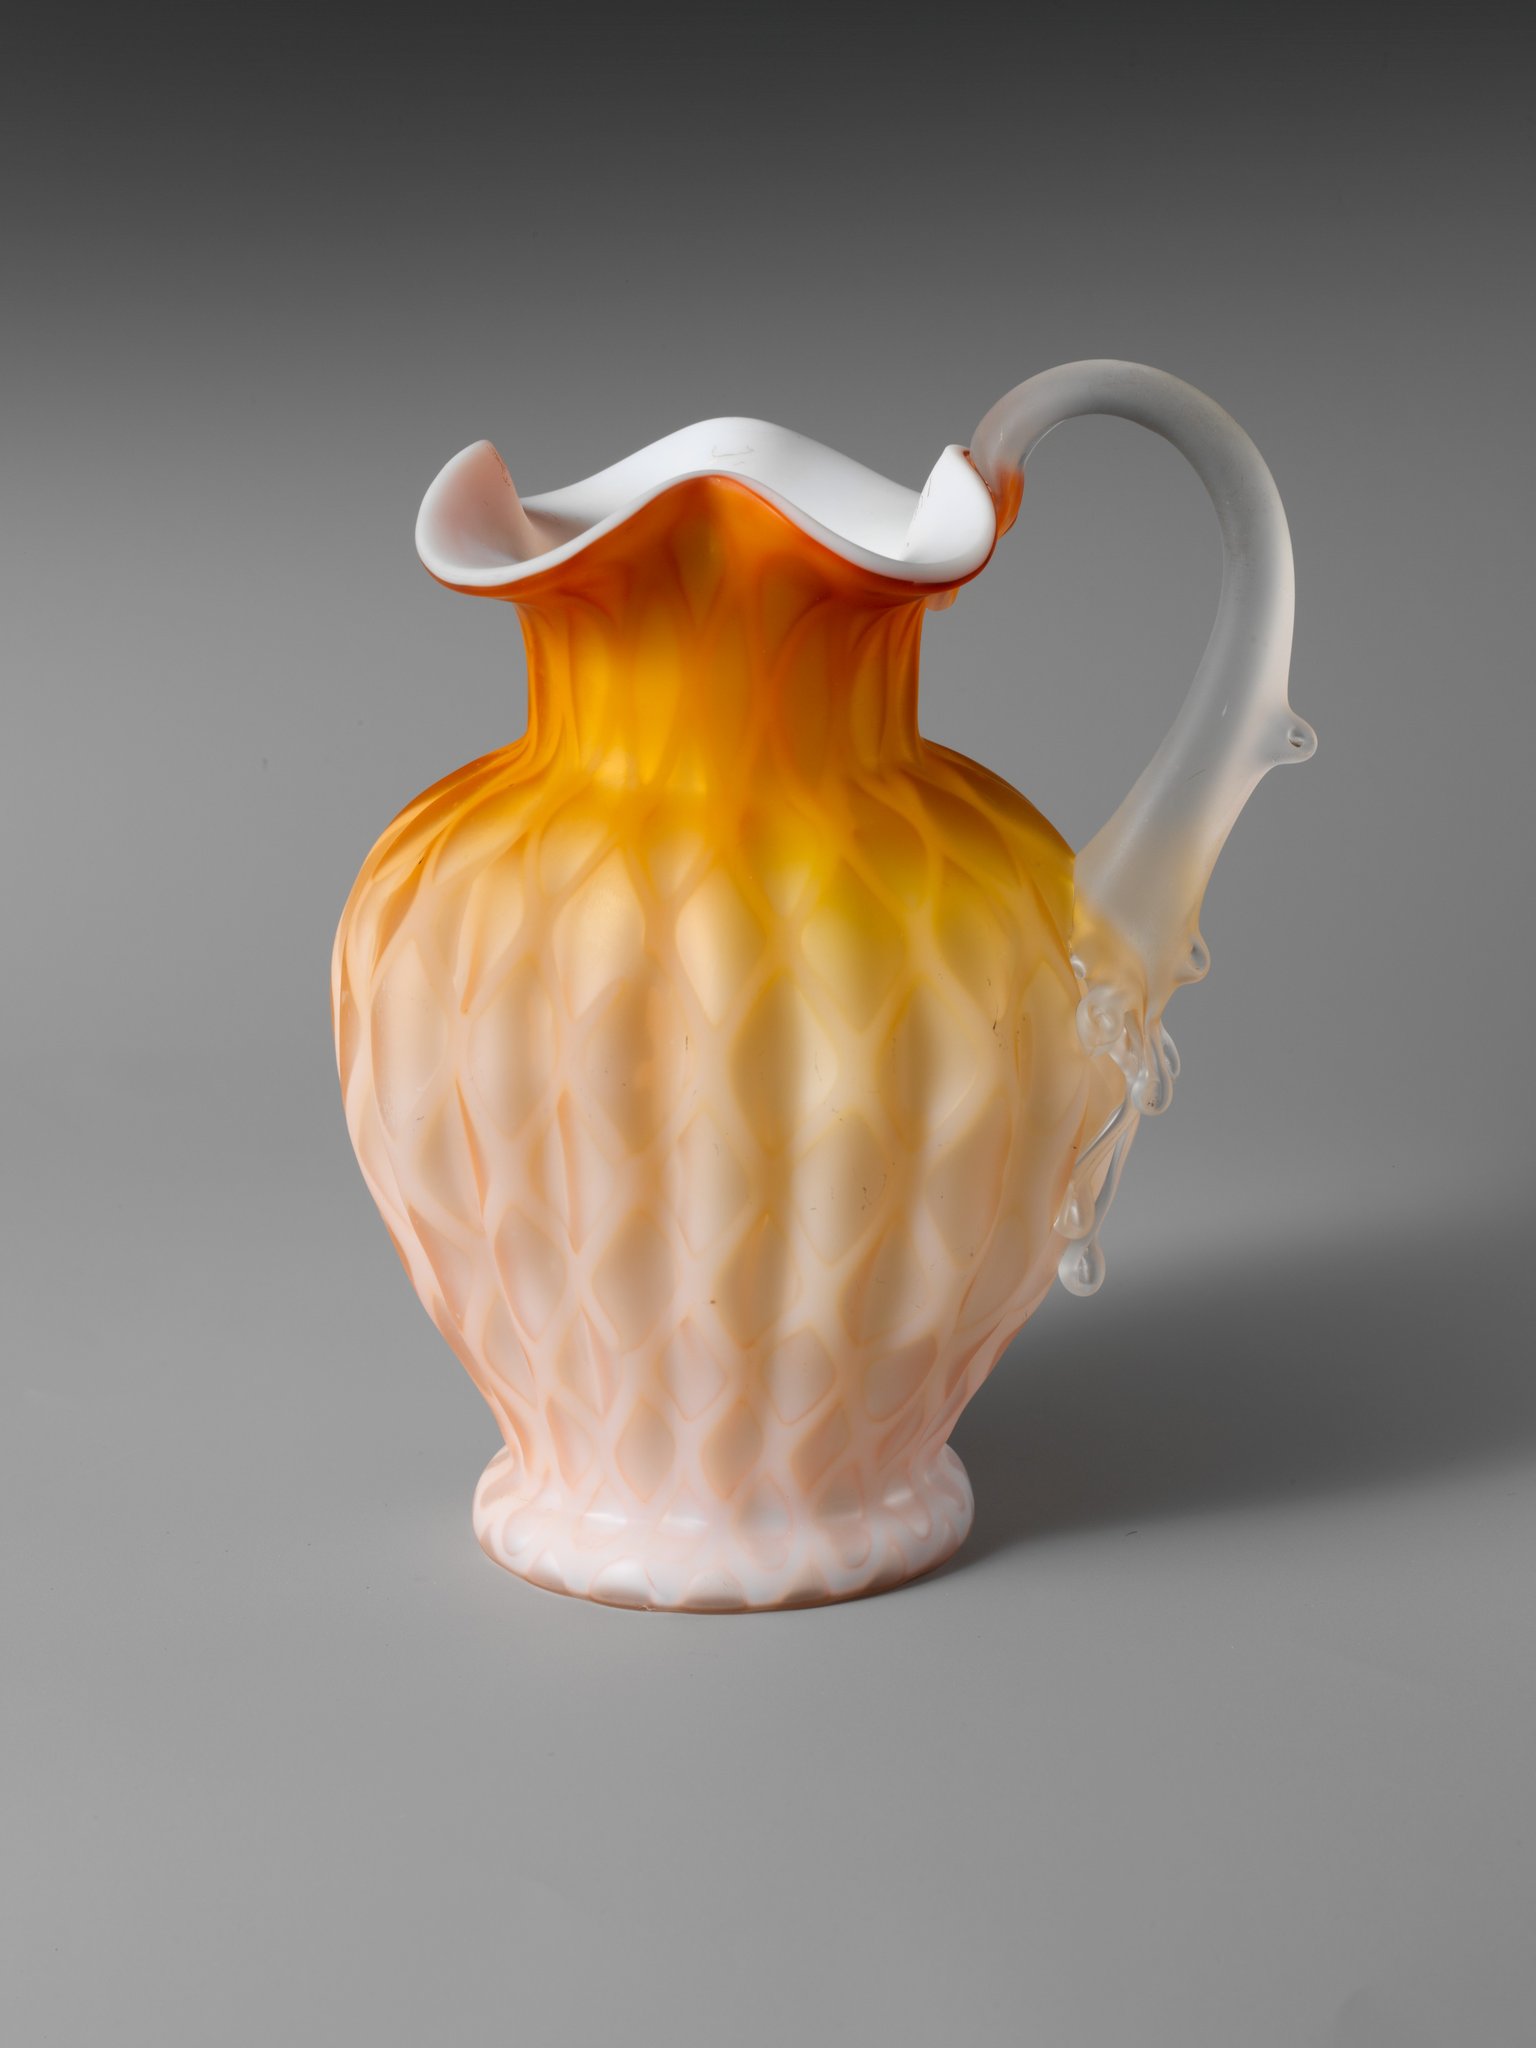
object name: pitcher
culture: american or british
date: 1885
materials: glass, textile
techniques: glassblowing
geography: england